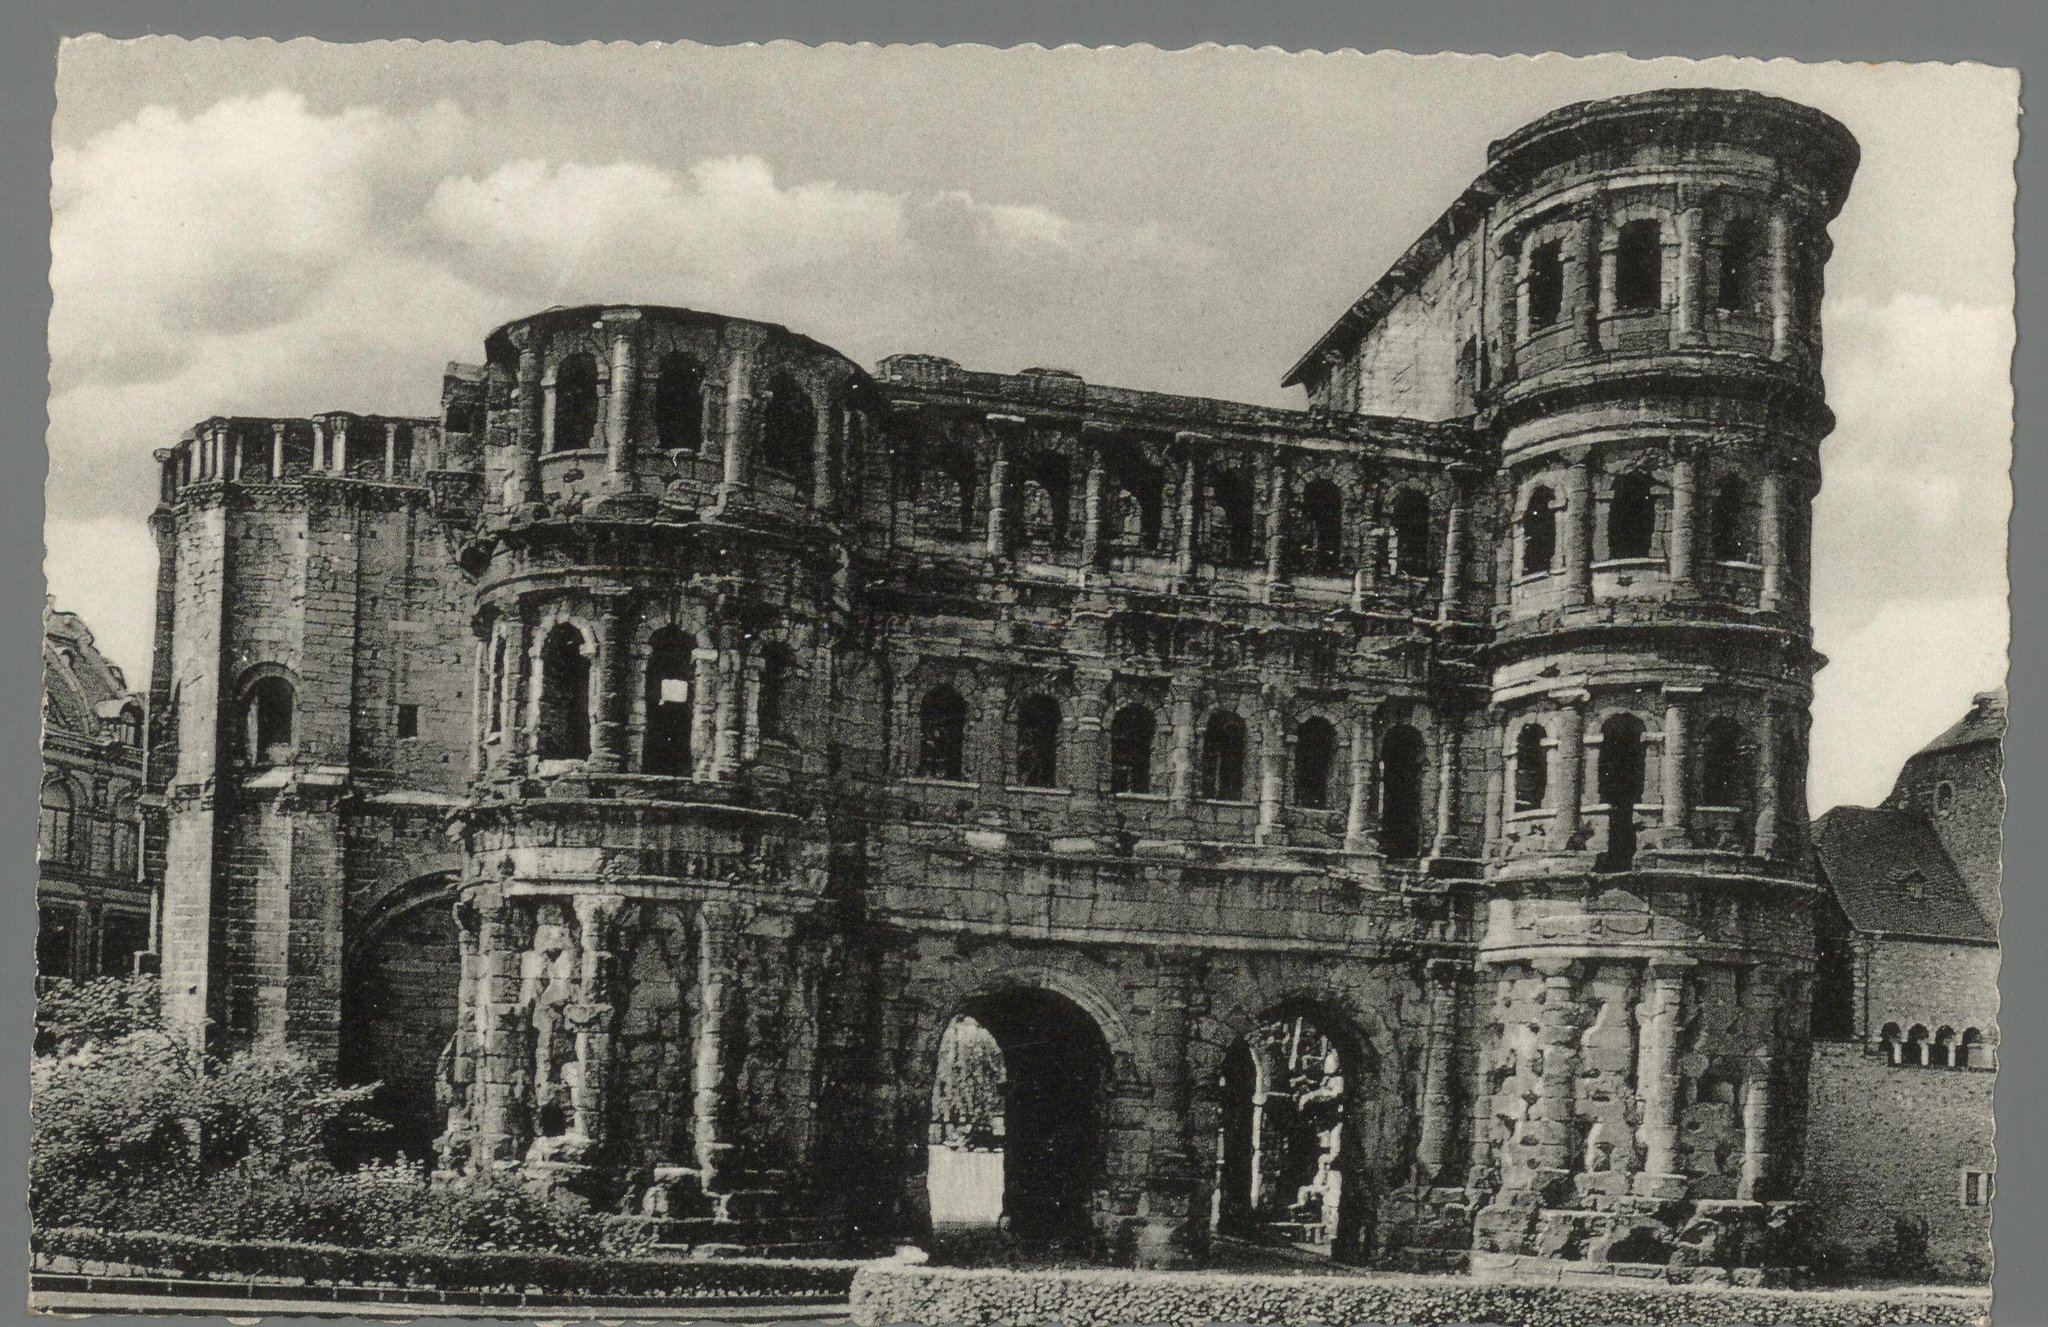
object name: ansichtkaart, prentbriefkaart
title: Trier - Porta Nigra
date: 1935-1950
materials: cardboard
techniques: photograph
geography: trier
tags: city-gate